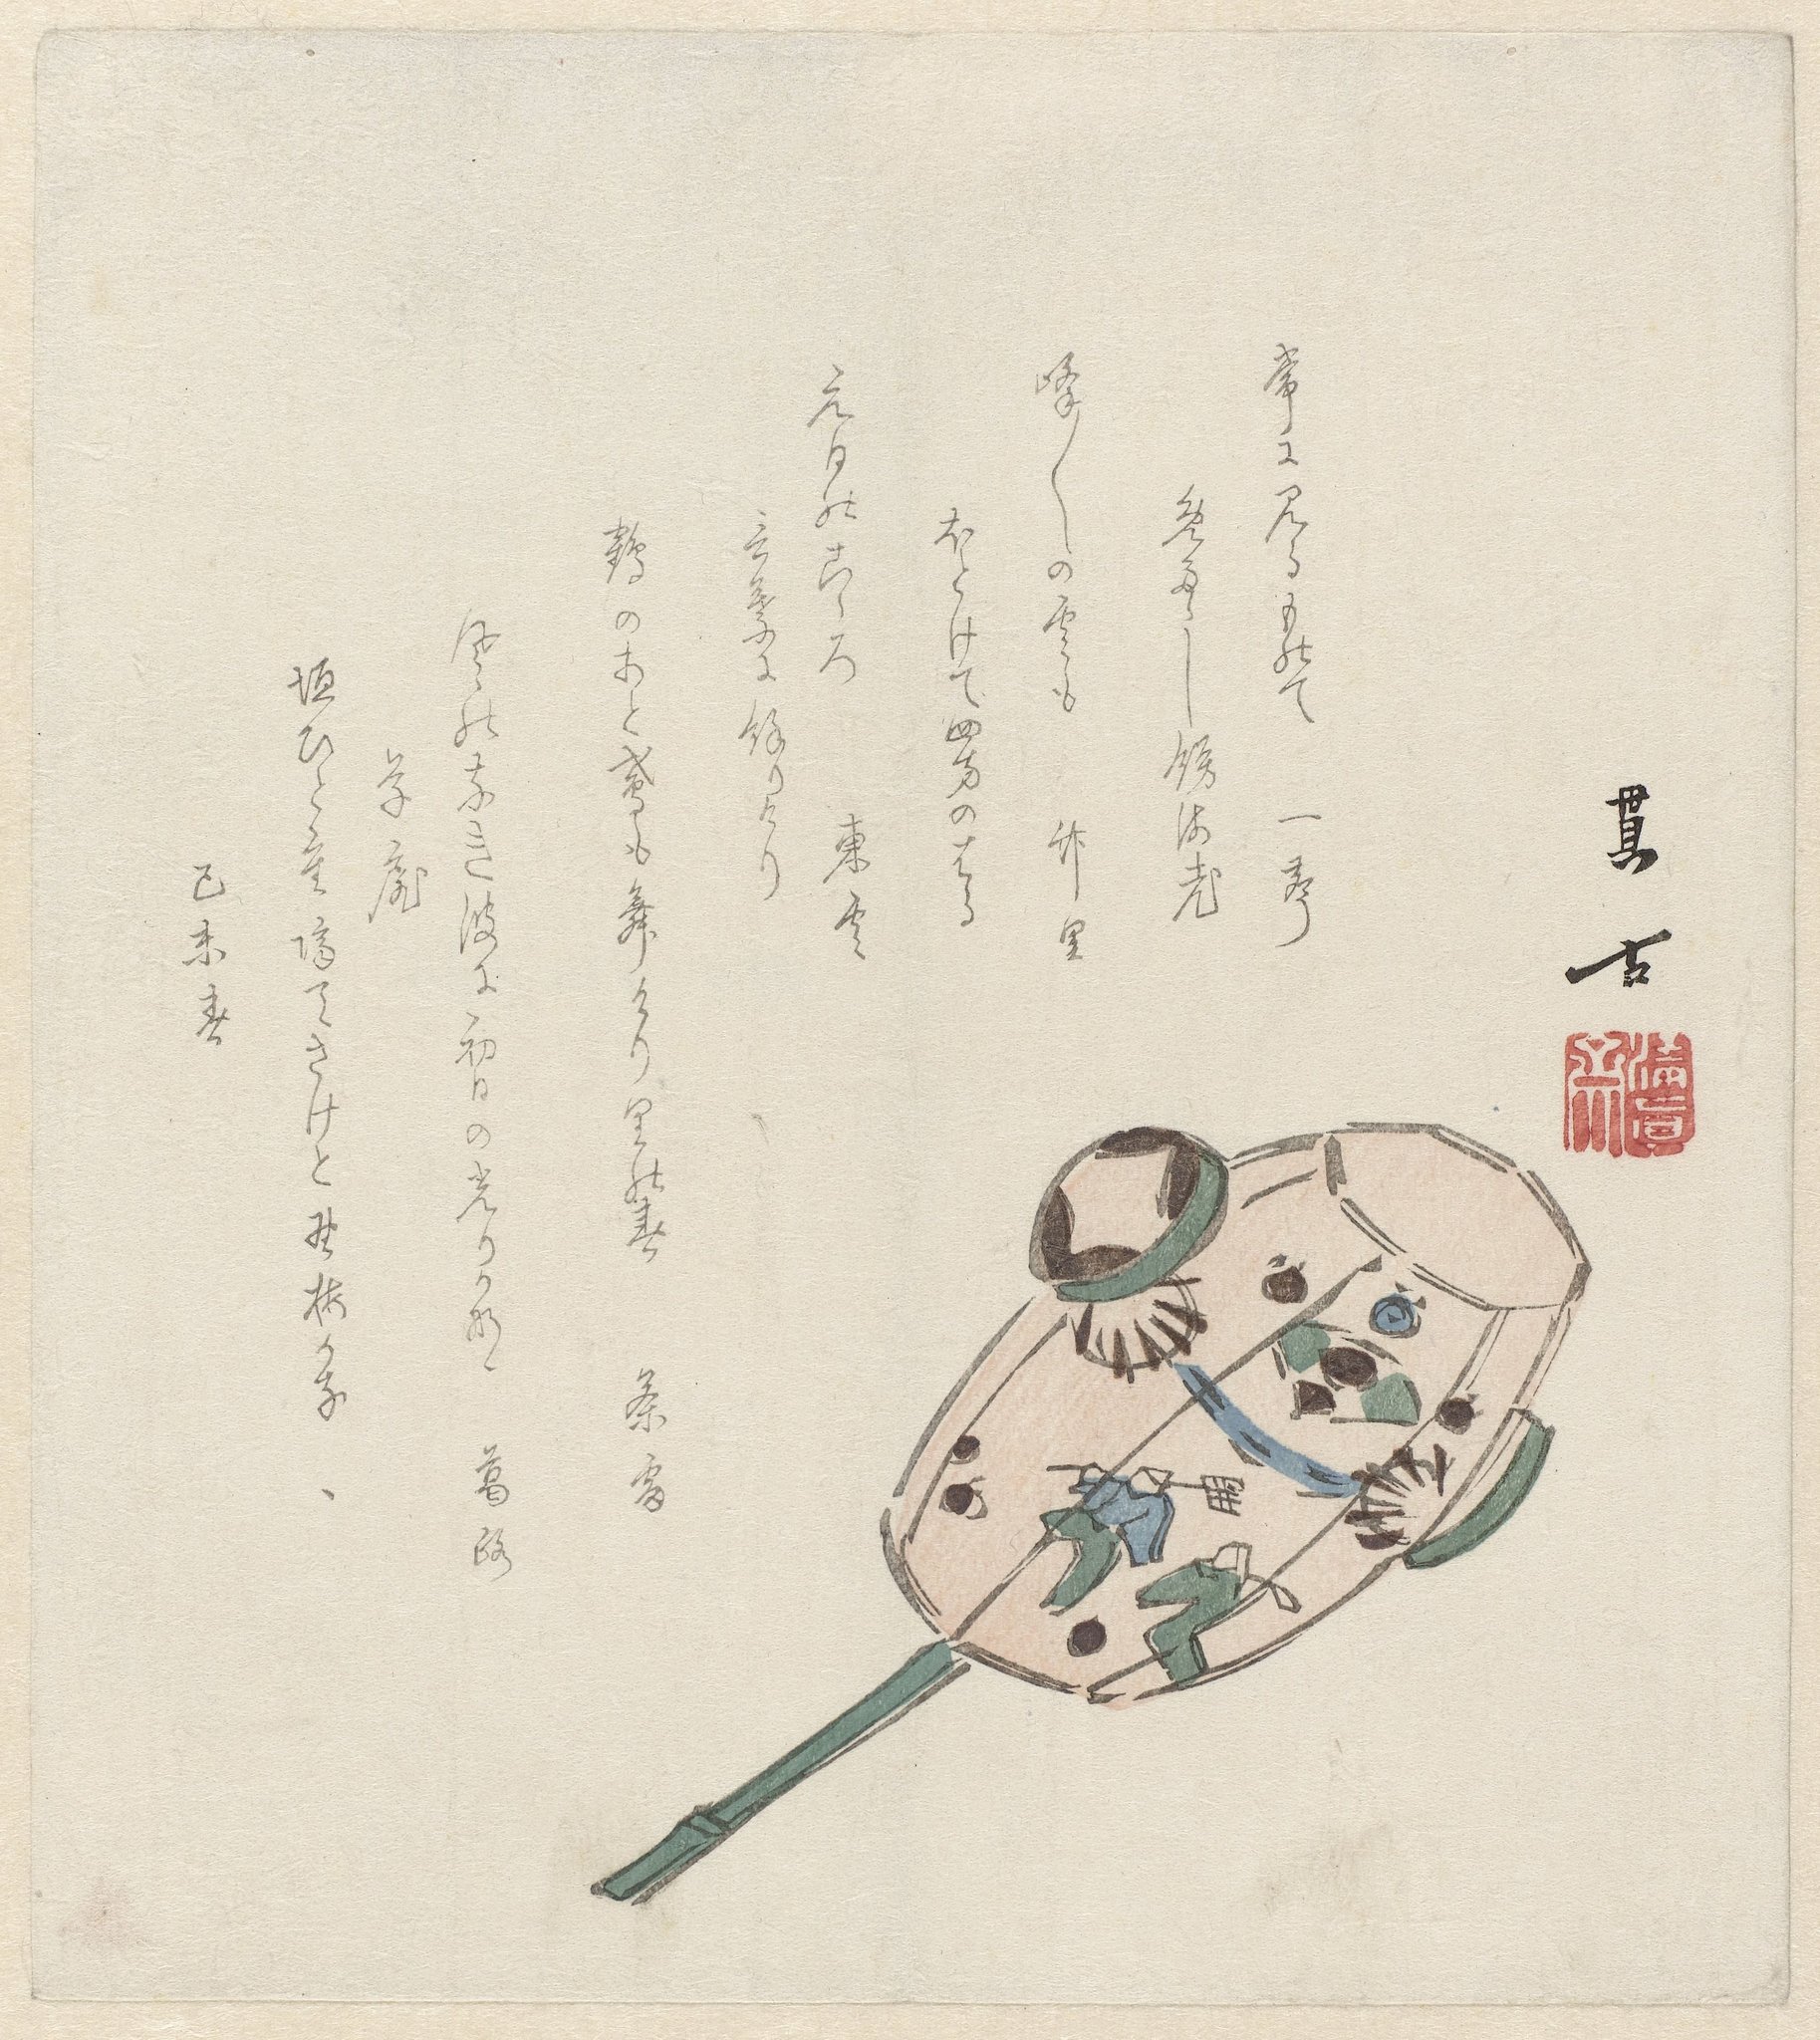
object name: surimono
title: Doosje(?)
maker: kanko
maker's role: print maker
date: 1859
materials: paper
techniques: woodcut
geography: japan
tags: containers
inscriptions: collector's mark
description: Een surimono is een luxe uitgevoerde prent waarop beeld met één of meerdere gedichten gecombineerd is. Bij het drukken van een surimono werd vaak gebruik gemaakt van dikker papier, blinddruk en metaal pigmenten, zoals koper- en zilverpoeder. De prenten werden vaak in opdracht van dichters gemaakt en als exclusief geschenk aan vrienden en relaties gegeven.